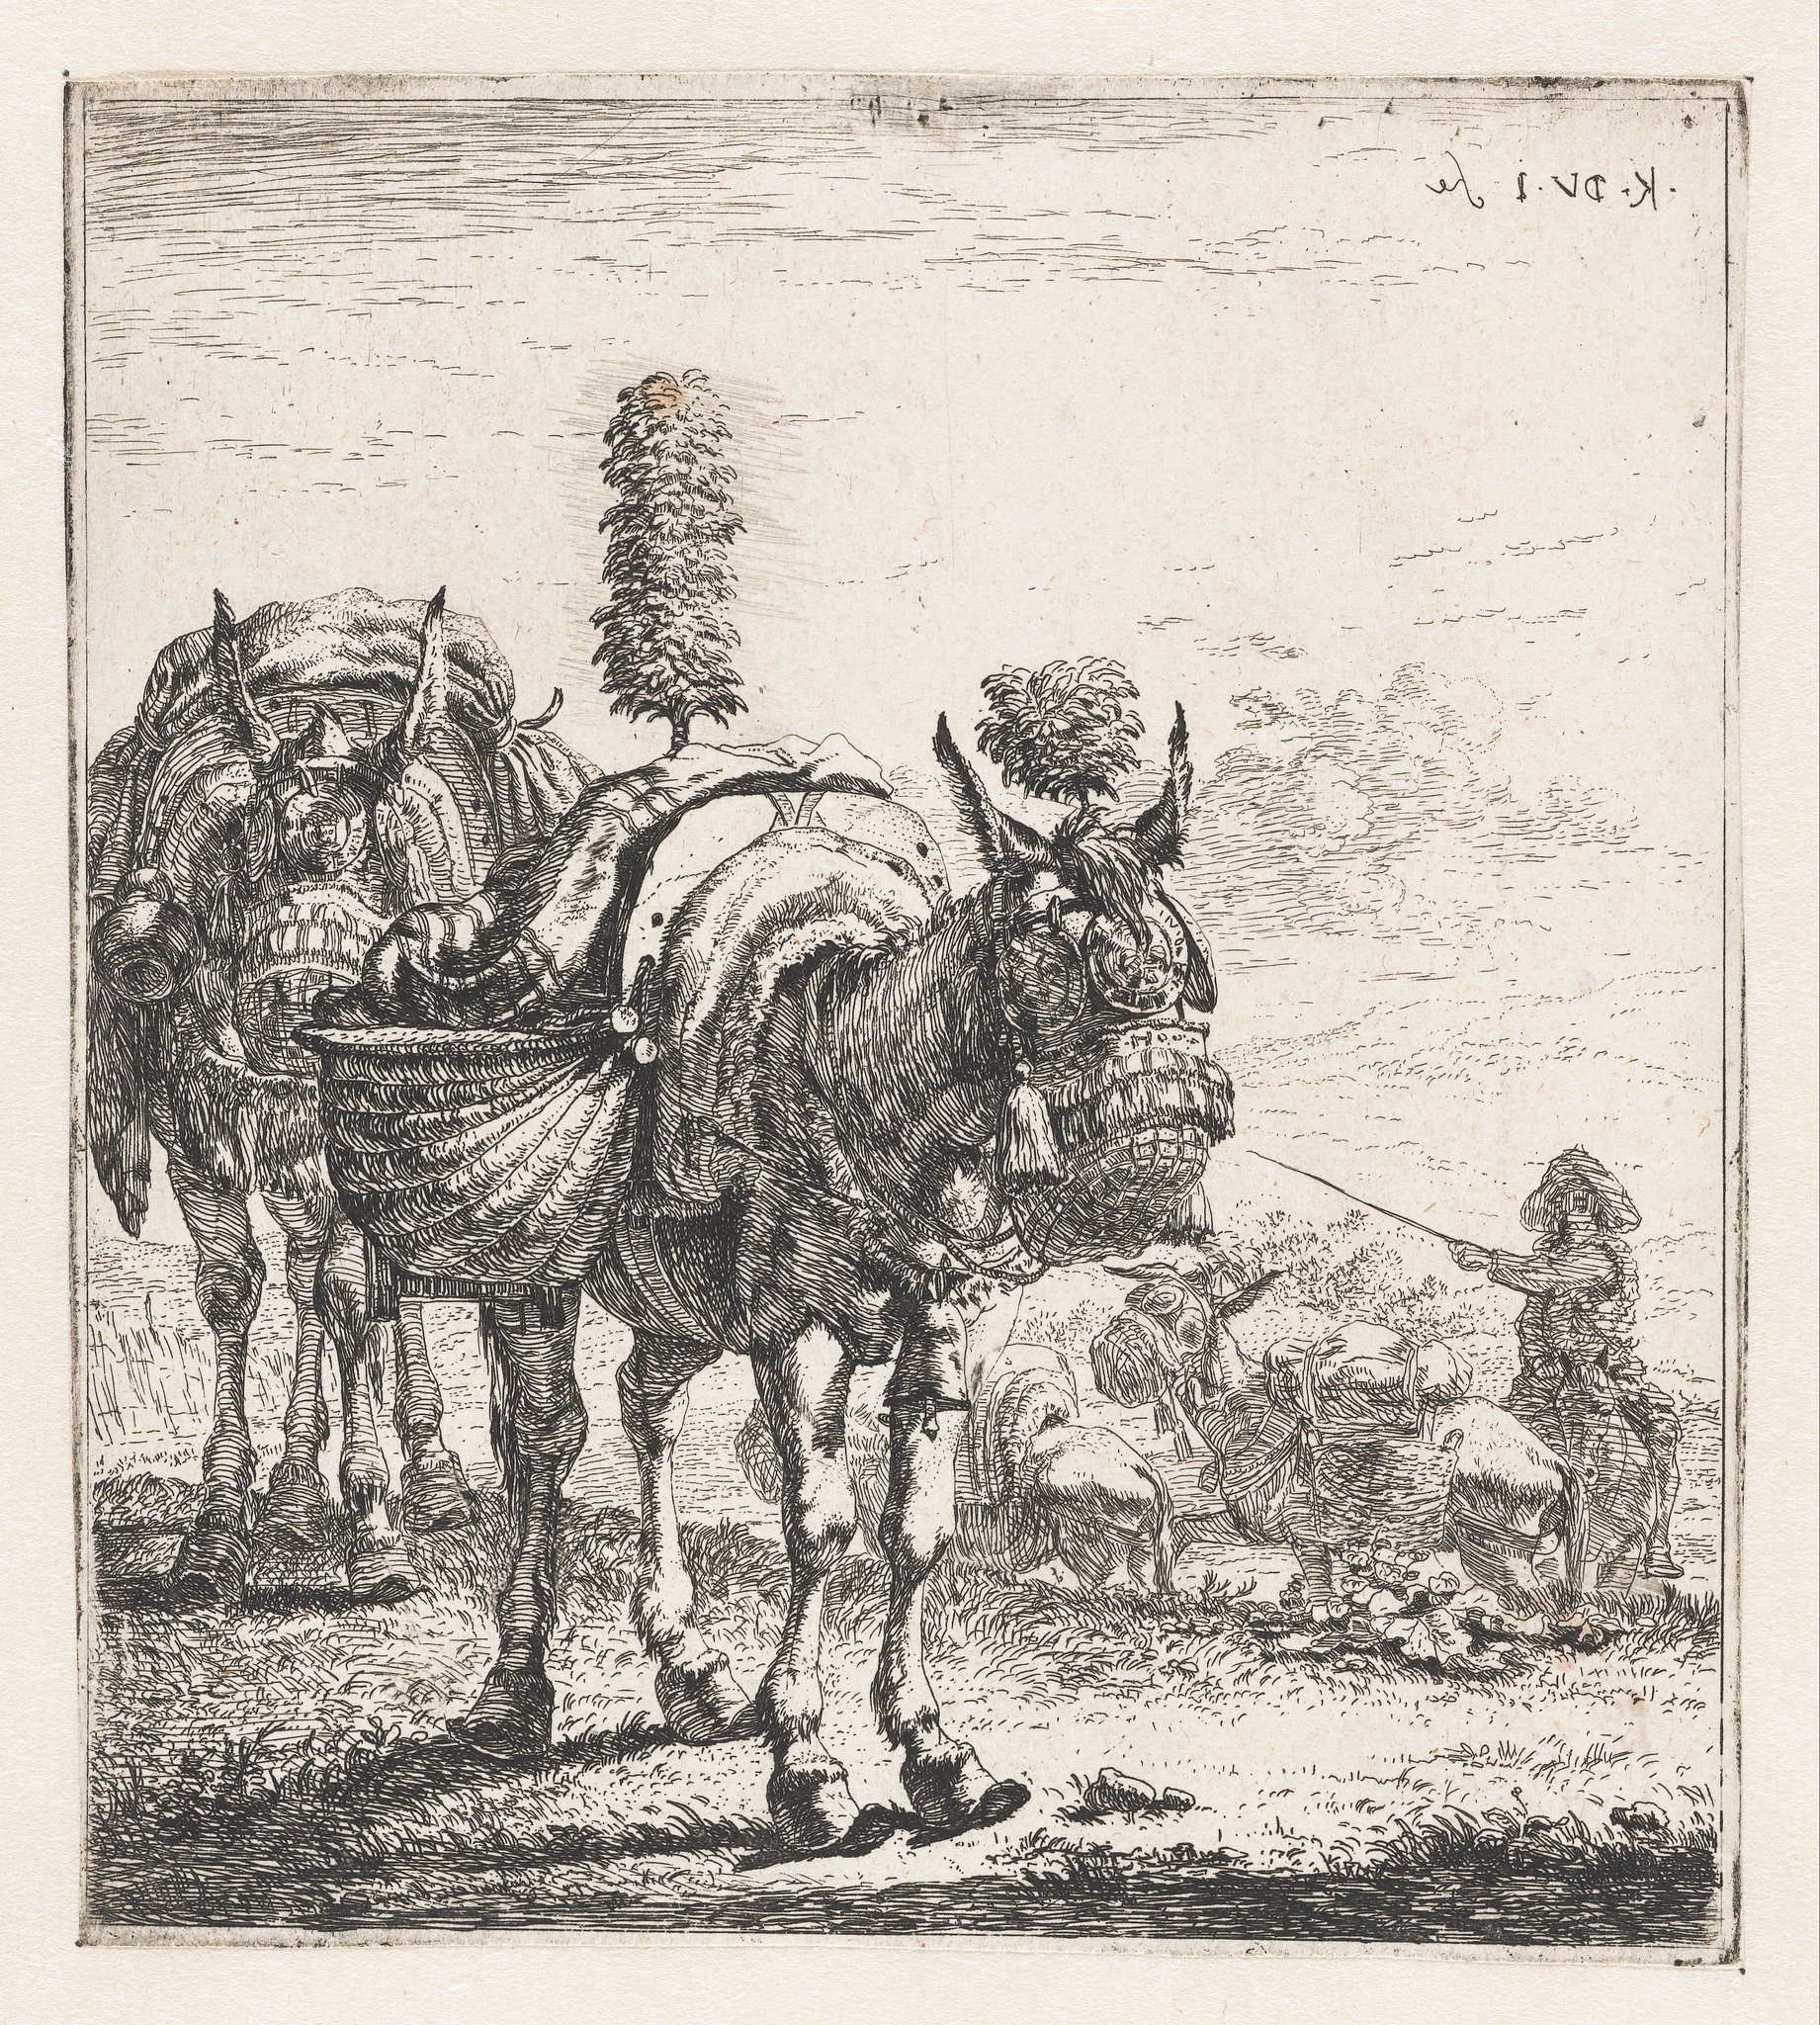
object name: print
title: Dieren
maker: karel du jardin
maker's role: draughtsman, painter, print maker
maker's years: 1626-1678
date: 1652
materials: paper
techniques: etching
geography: amsterdam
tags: mule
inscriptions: collector's mark: Lugt 240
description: Prent nummer 2 uit een serie van acht prenten van verschillende dieren.